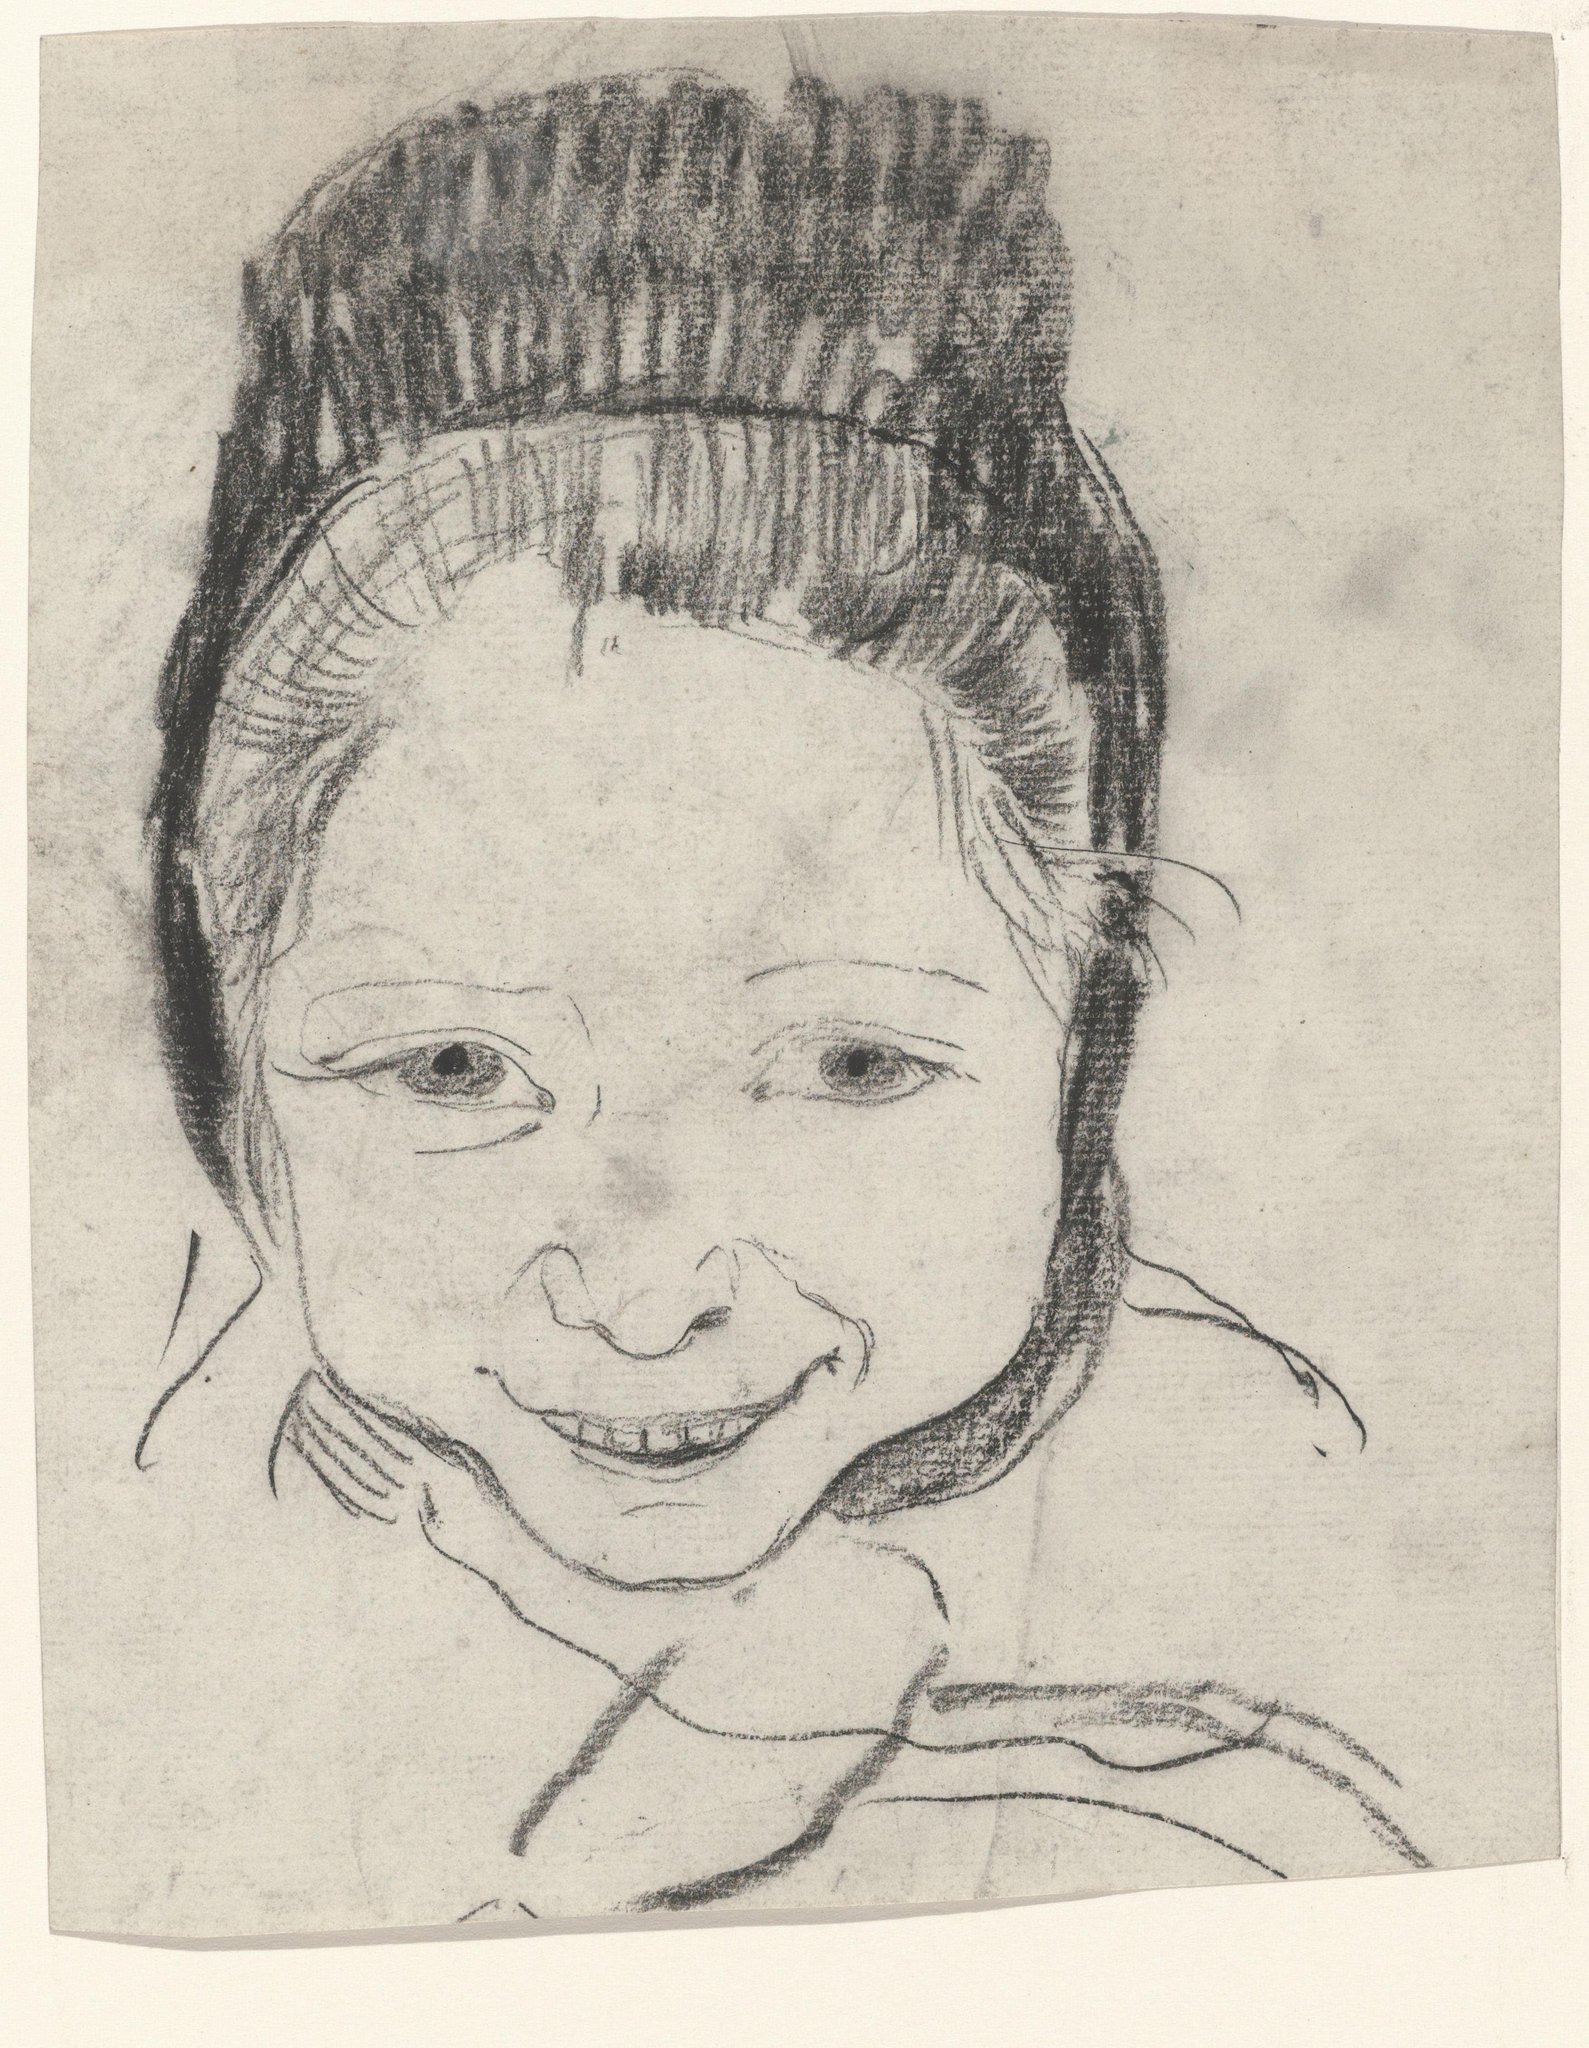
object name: drawing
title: Hoofd van een lachend meisje met een muts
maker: carel adolph lion cachet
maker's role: draughtsman, print maker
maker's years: 1864-1945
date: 1874-1945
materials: chalk, paper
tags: head-gear: cap (+ men's clothes)